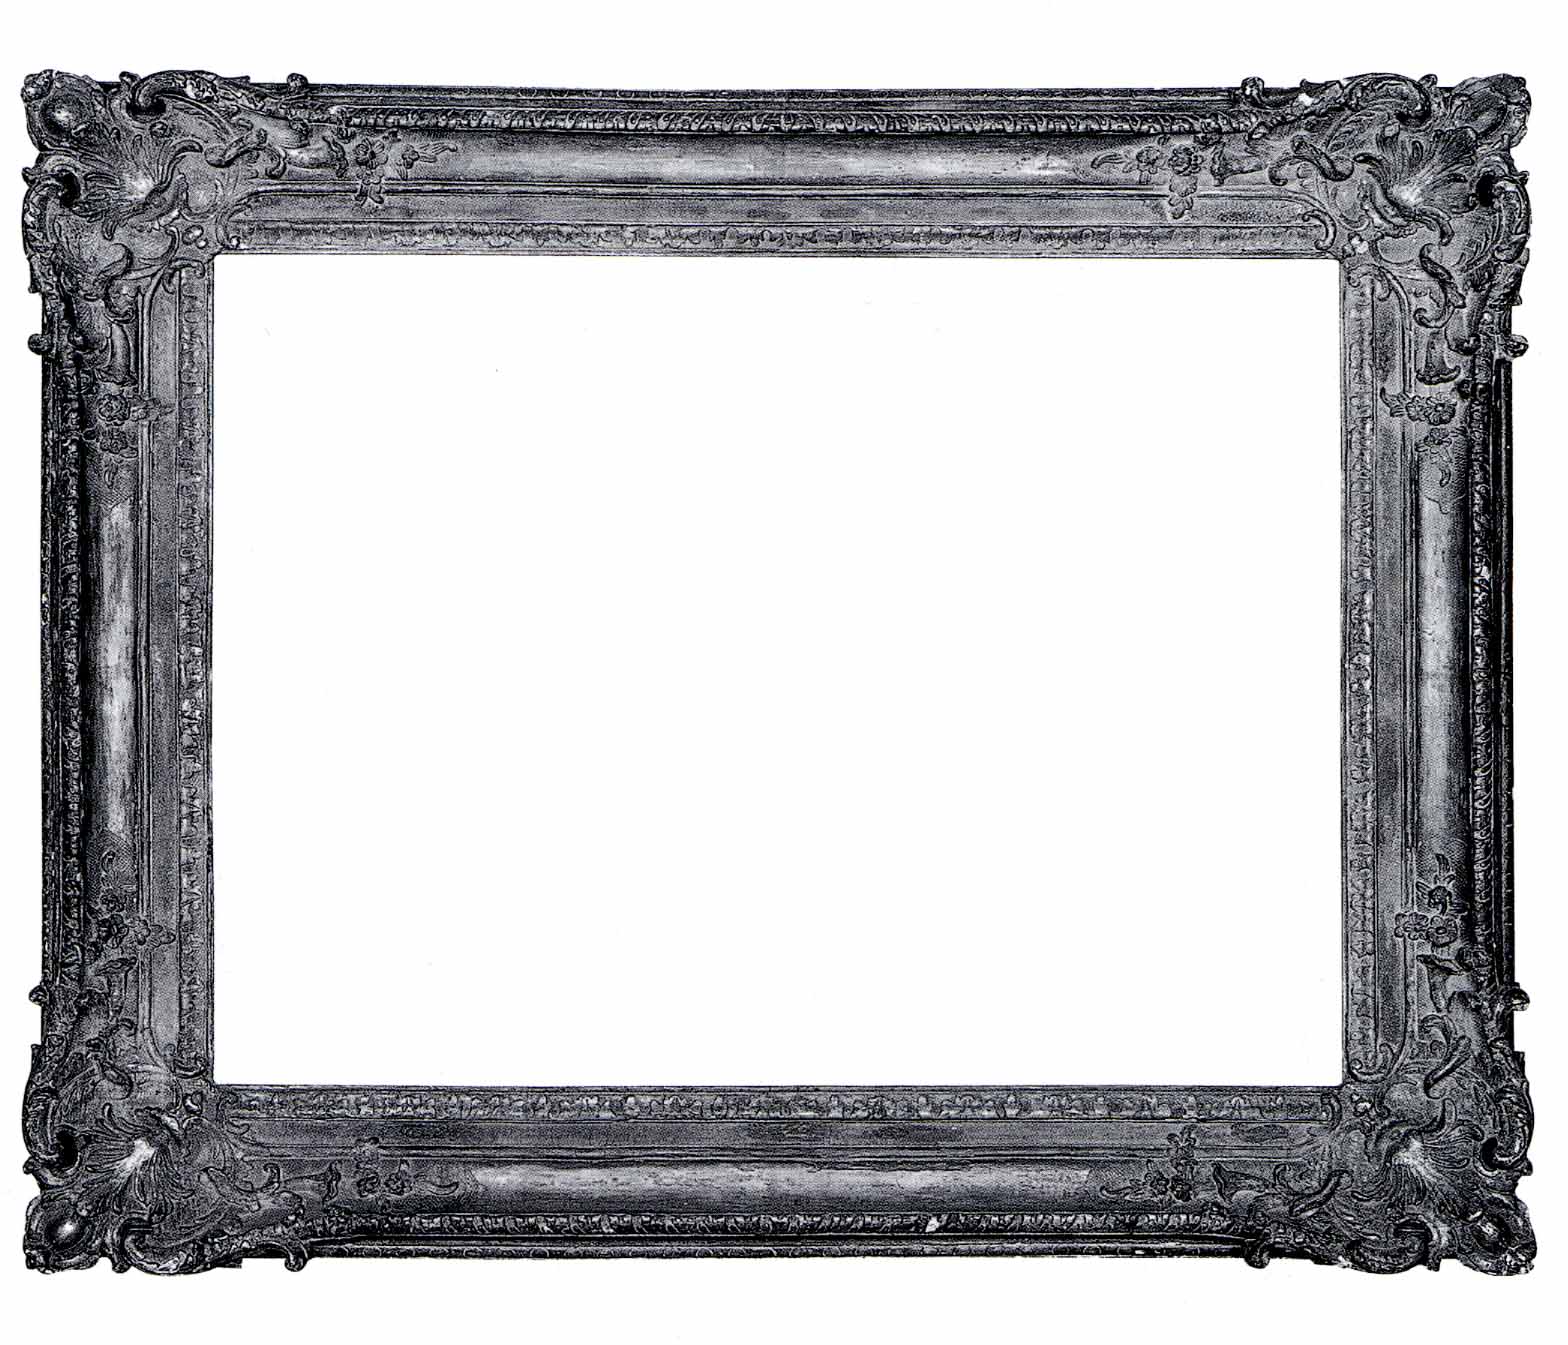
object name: frame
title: Ogee frame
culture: french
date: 1720-1725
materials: gilt, wood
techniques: carving